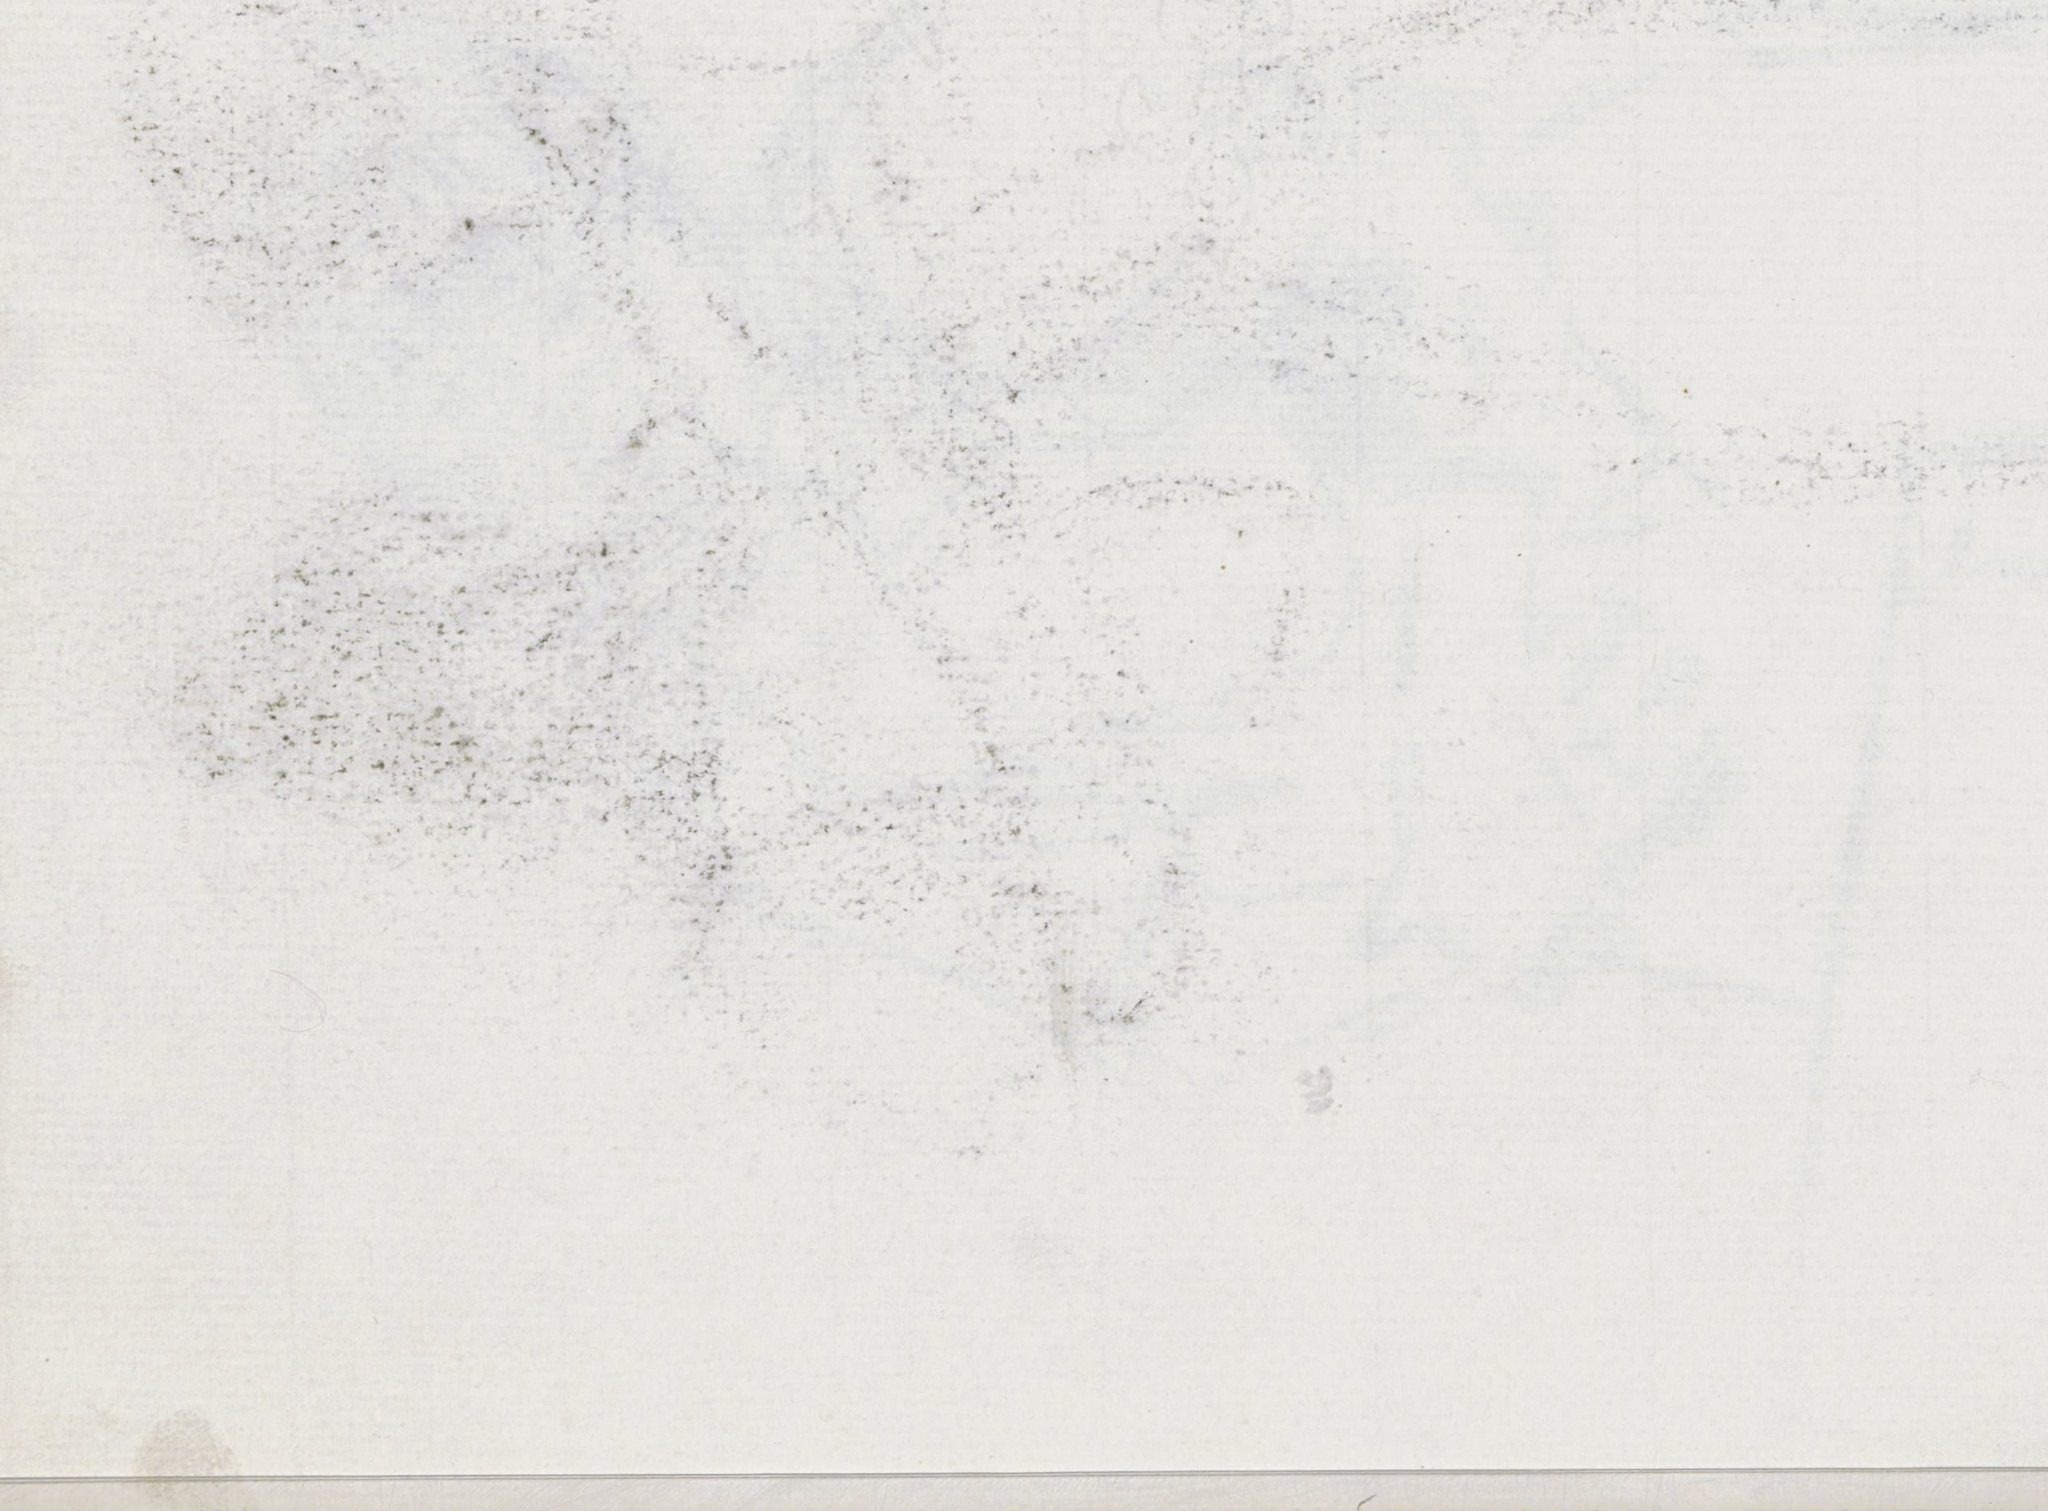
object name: sketchbook leaf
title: Abklatsch van de krijttekening op blad 2 recto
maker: isaac israels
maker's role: draughtsman, painter, print maker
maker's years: 1865-1934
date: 1875-1934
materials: paper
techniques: printmaking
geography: amsterdam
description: Blad 1 verso uit schetsboek XX met 26 bladen.